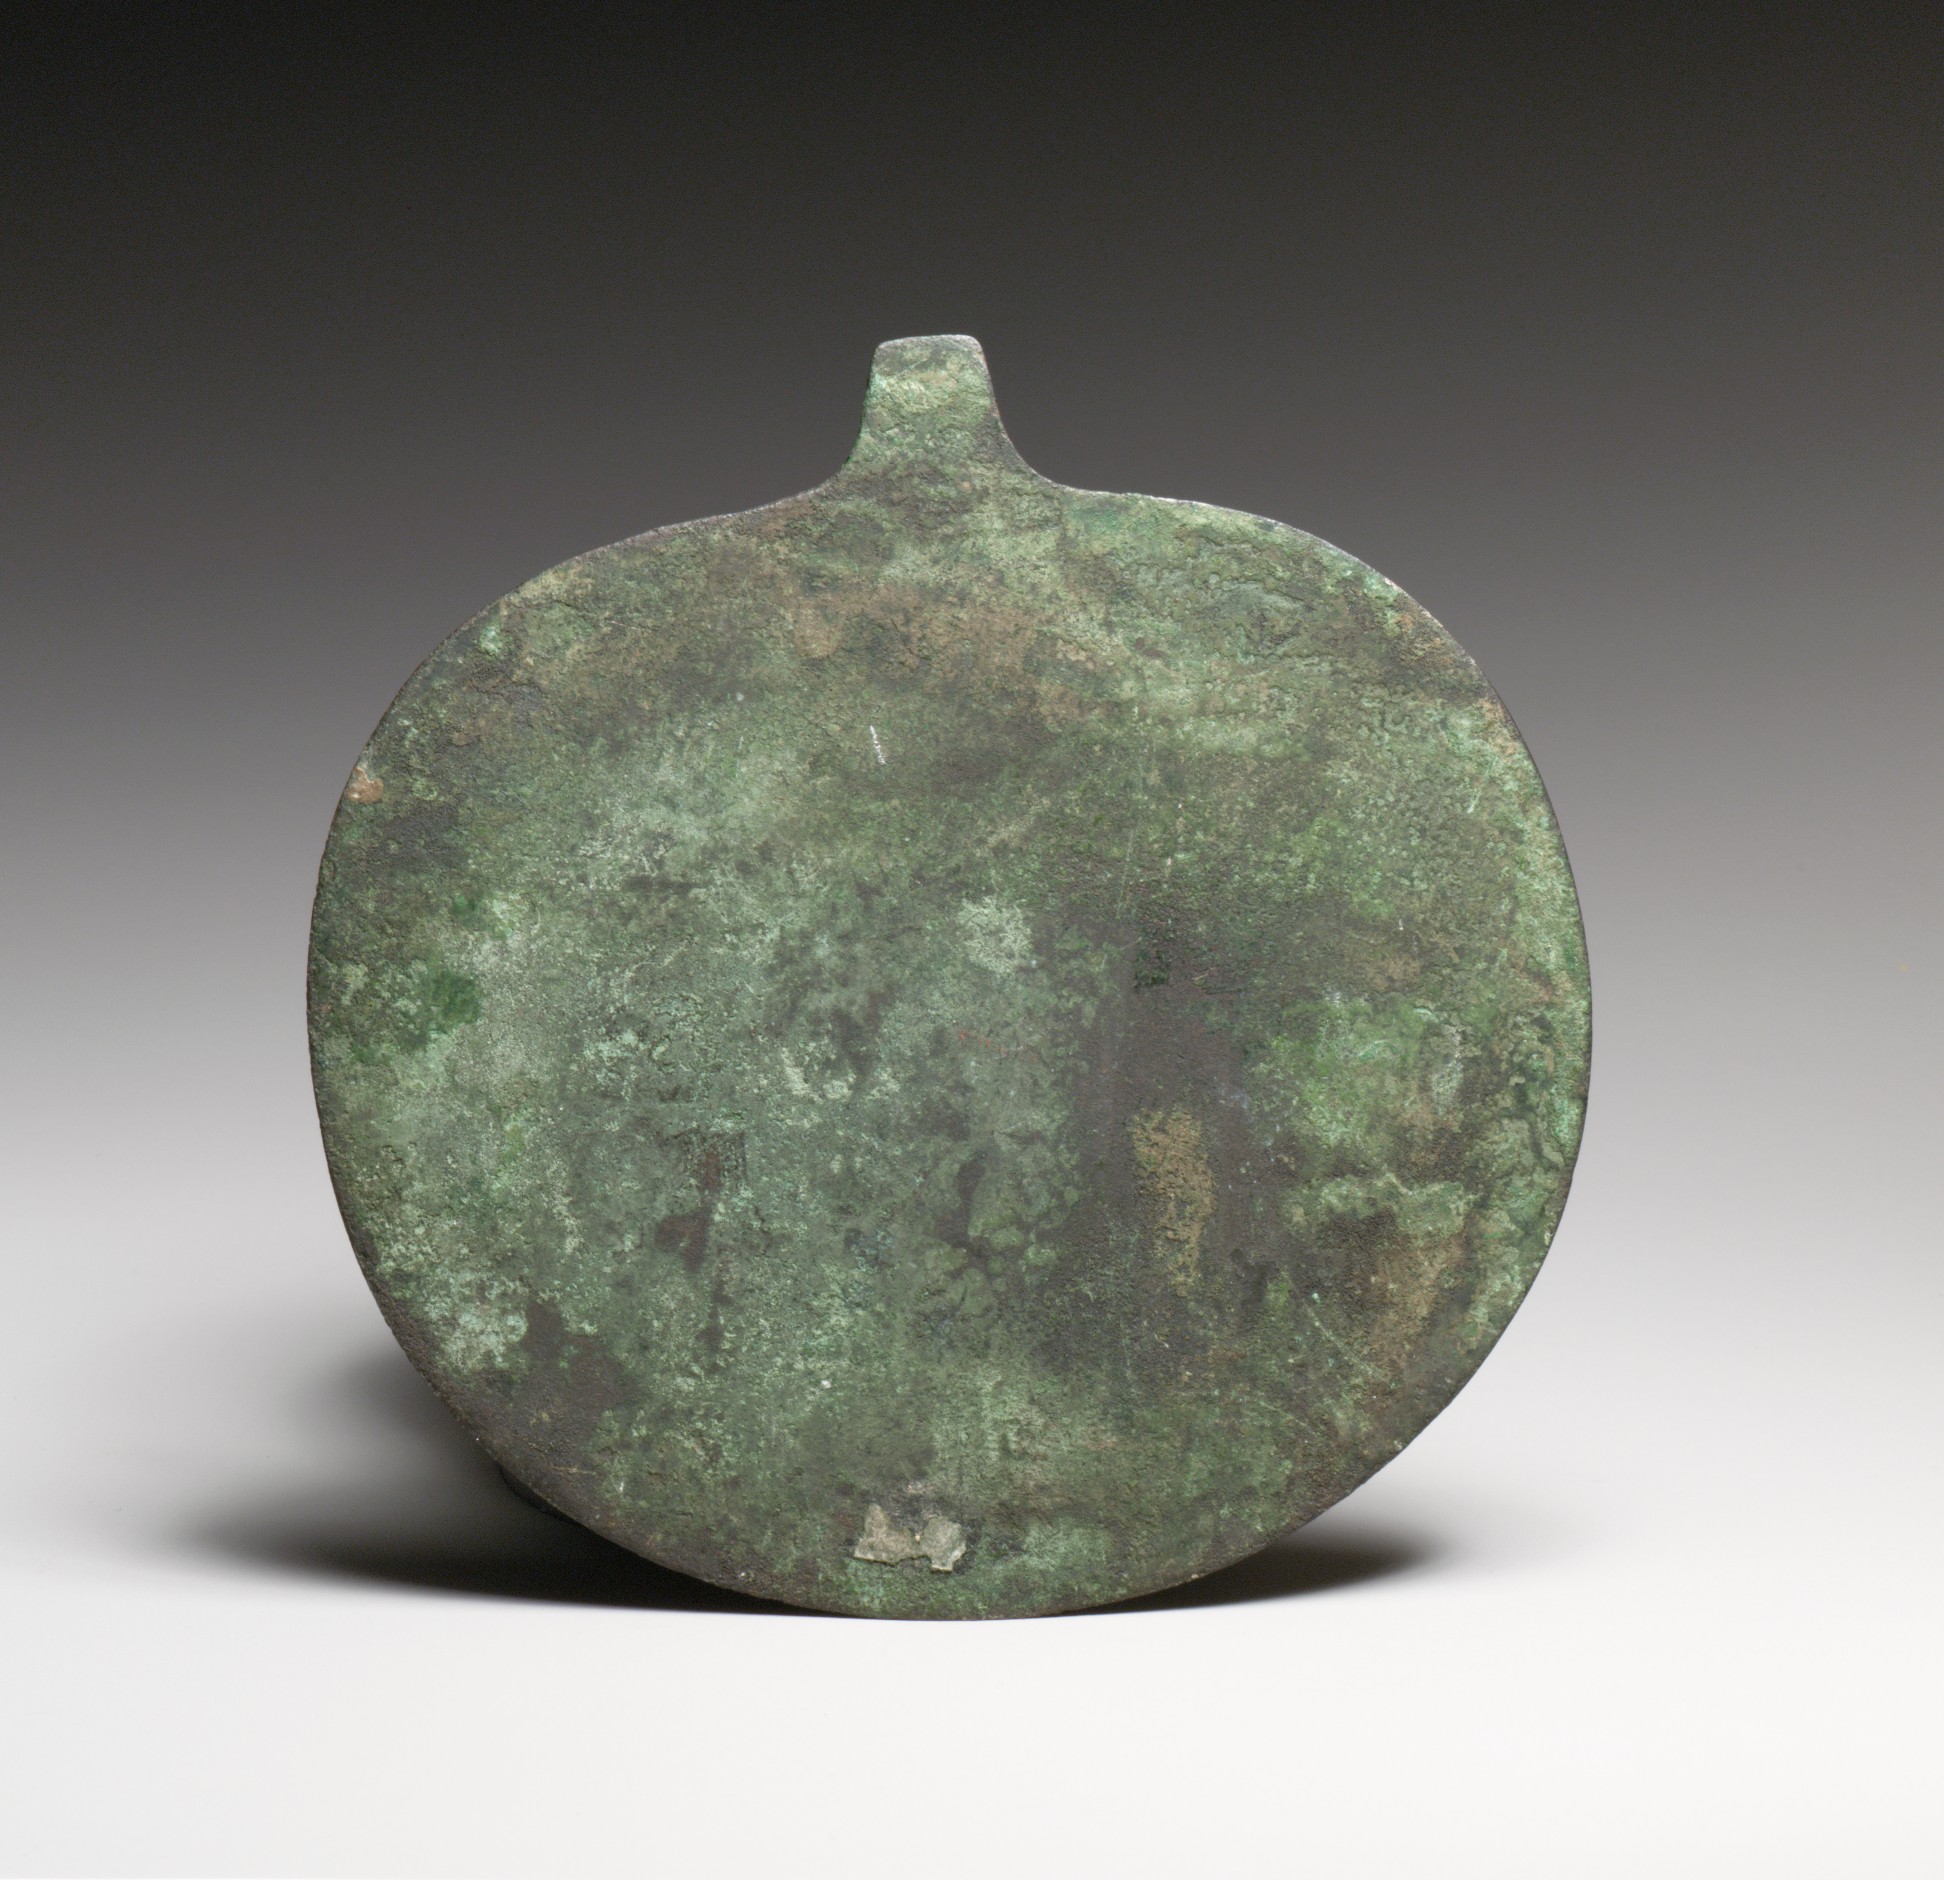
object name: mirror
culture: greek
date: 500-401 BCE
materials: bronze